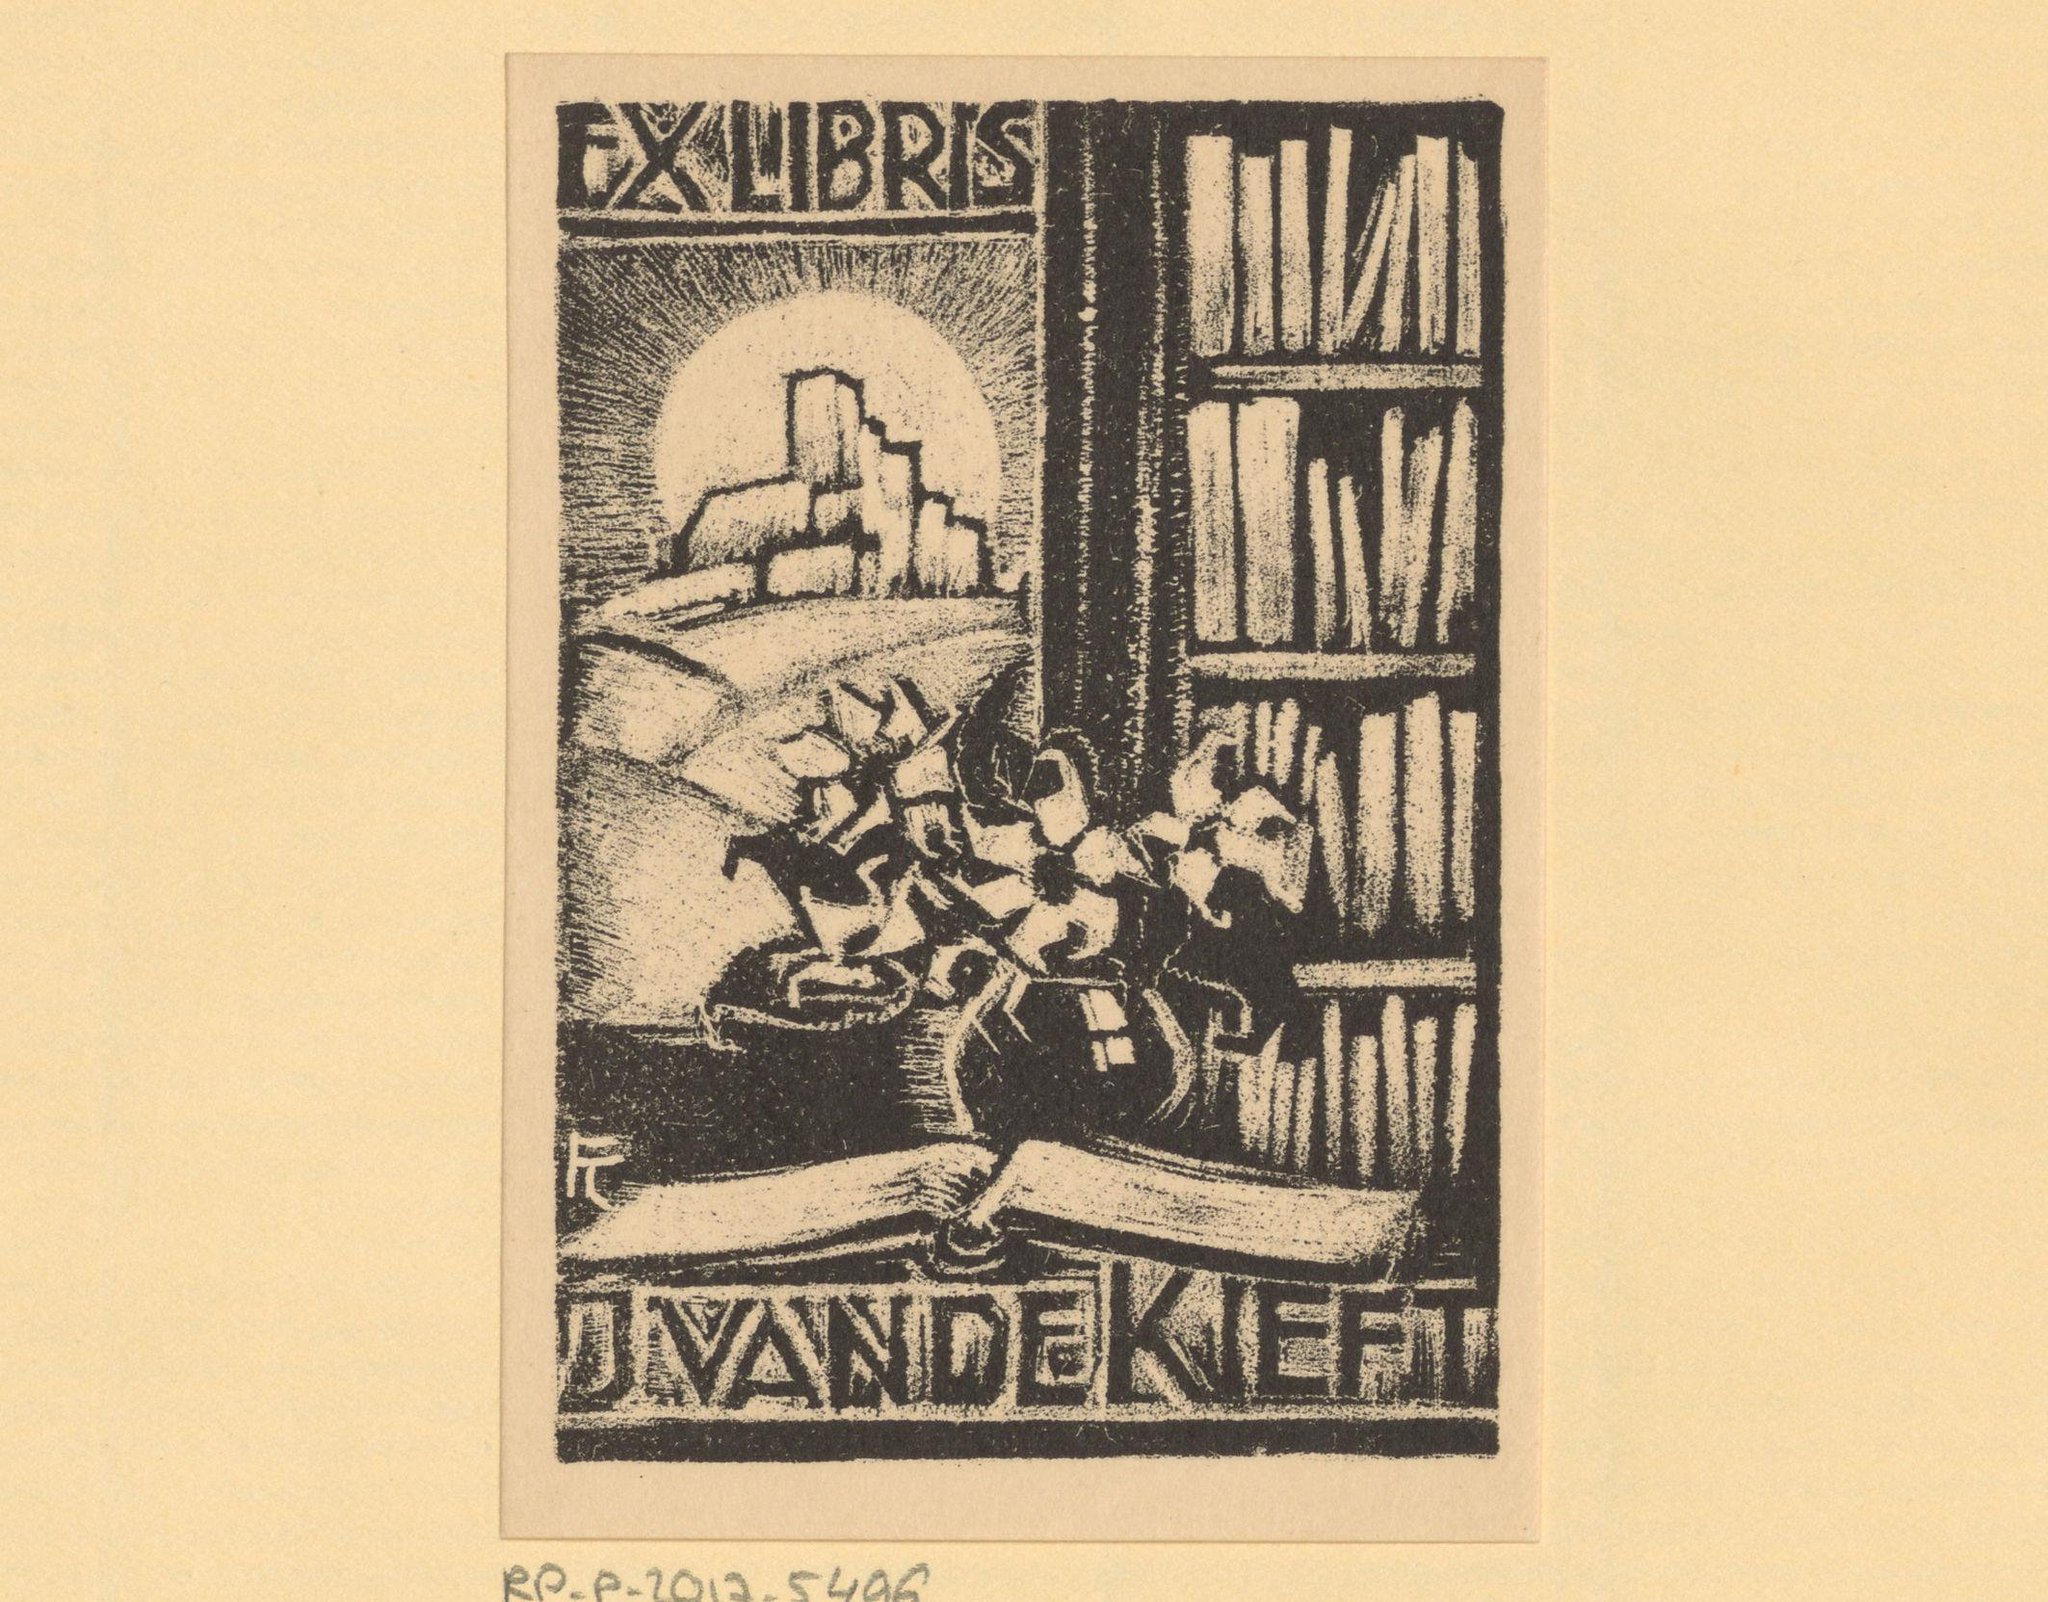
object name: bookplate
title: Ex libris van J. van de Kieft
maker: fré cohen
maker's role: draughtsman, print maker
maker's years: 1903-1943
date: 1913-1943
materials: paper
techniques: lithograph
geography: netherlands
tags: amsterdam, politician, bookshelves, view through a window, book, sun as celestial body